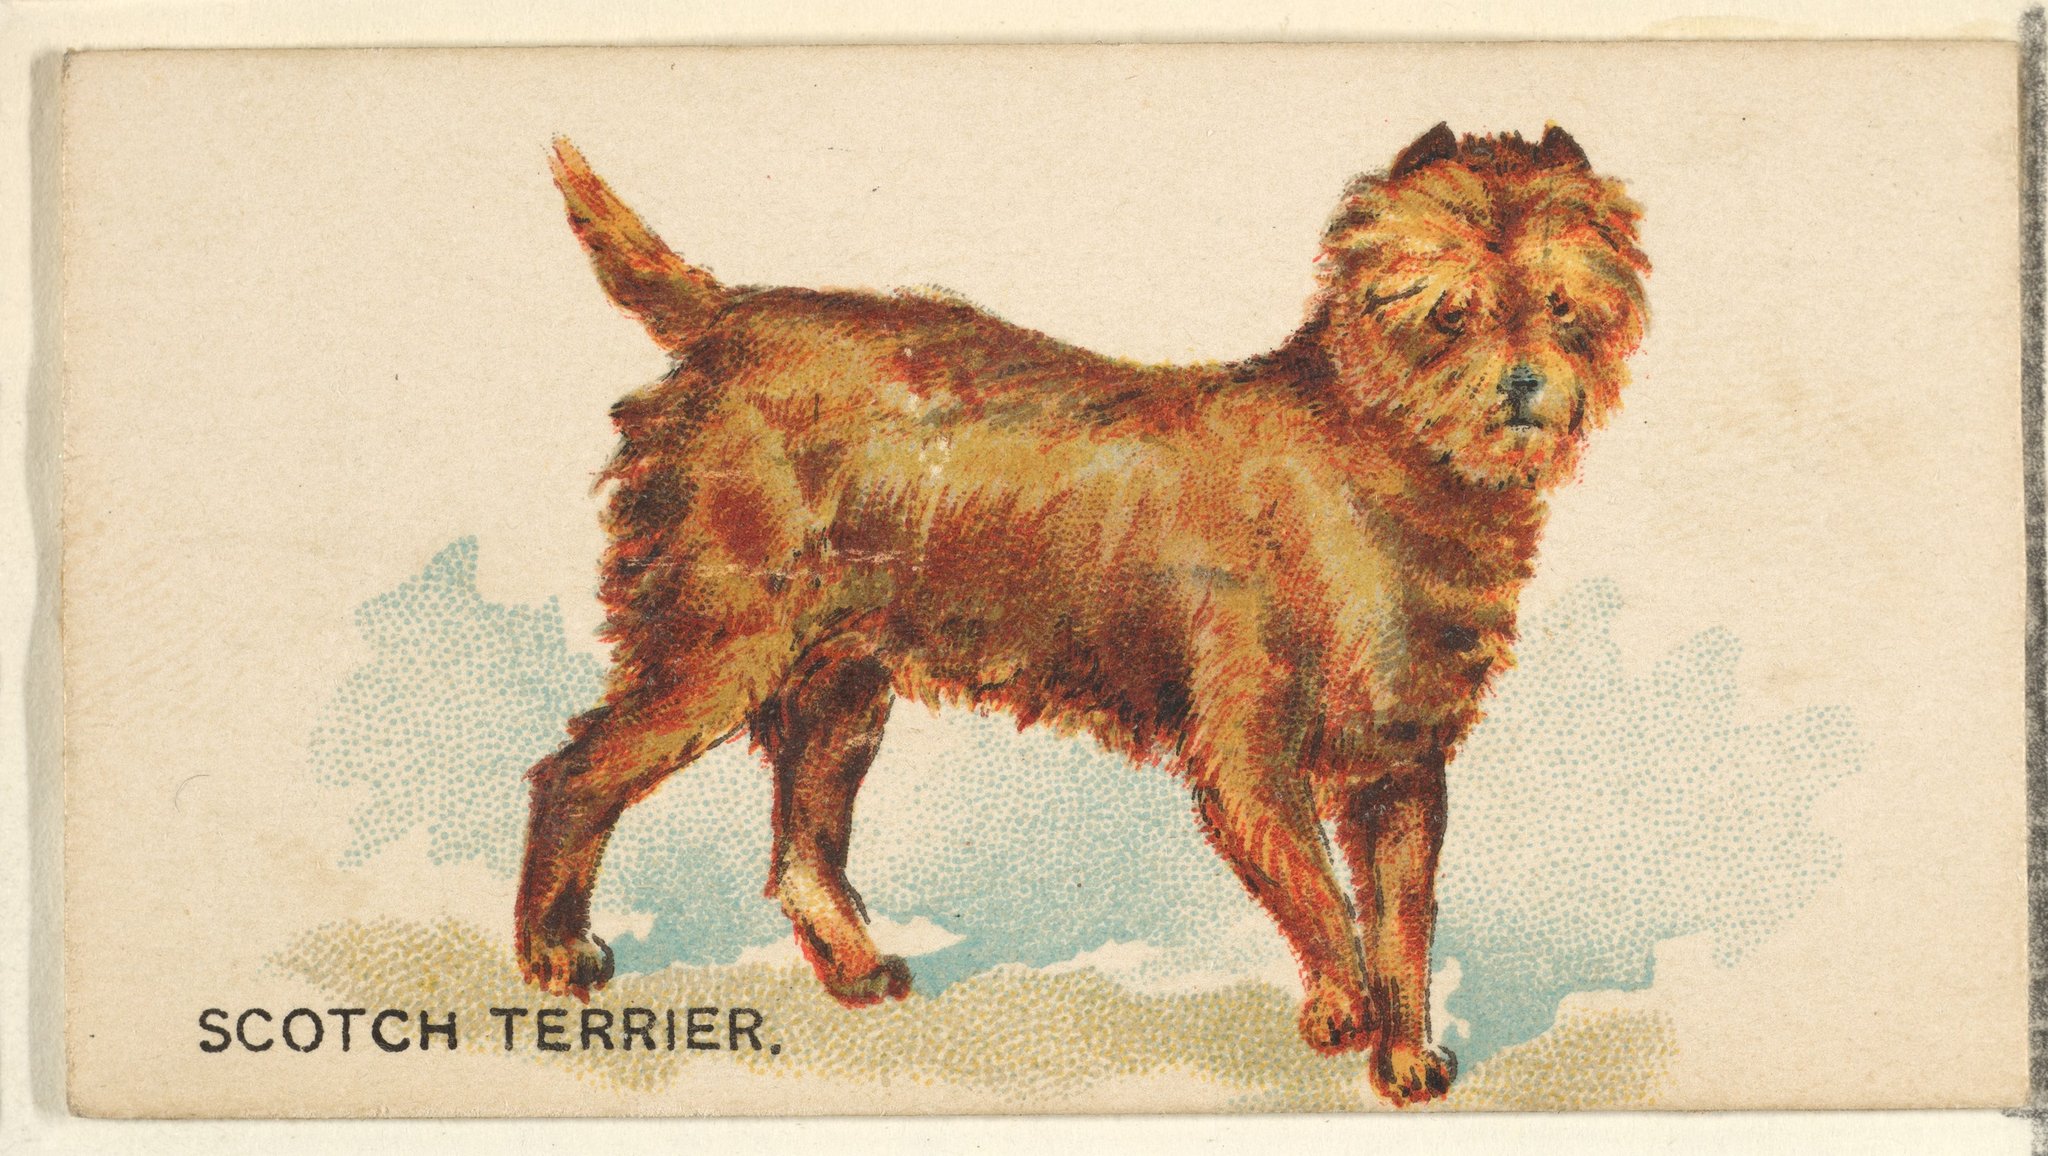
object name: print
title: Scotch Terrier, from the Dogs of the World series for Old Judge Cigarettes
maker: goodwin & company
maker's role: publisher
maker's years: 1850-1950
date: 1890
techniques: color lithograph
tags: dogs